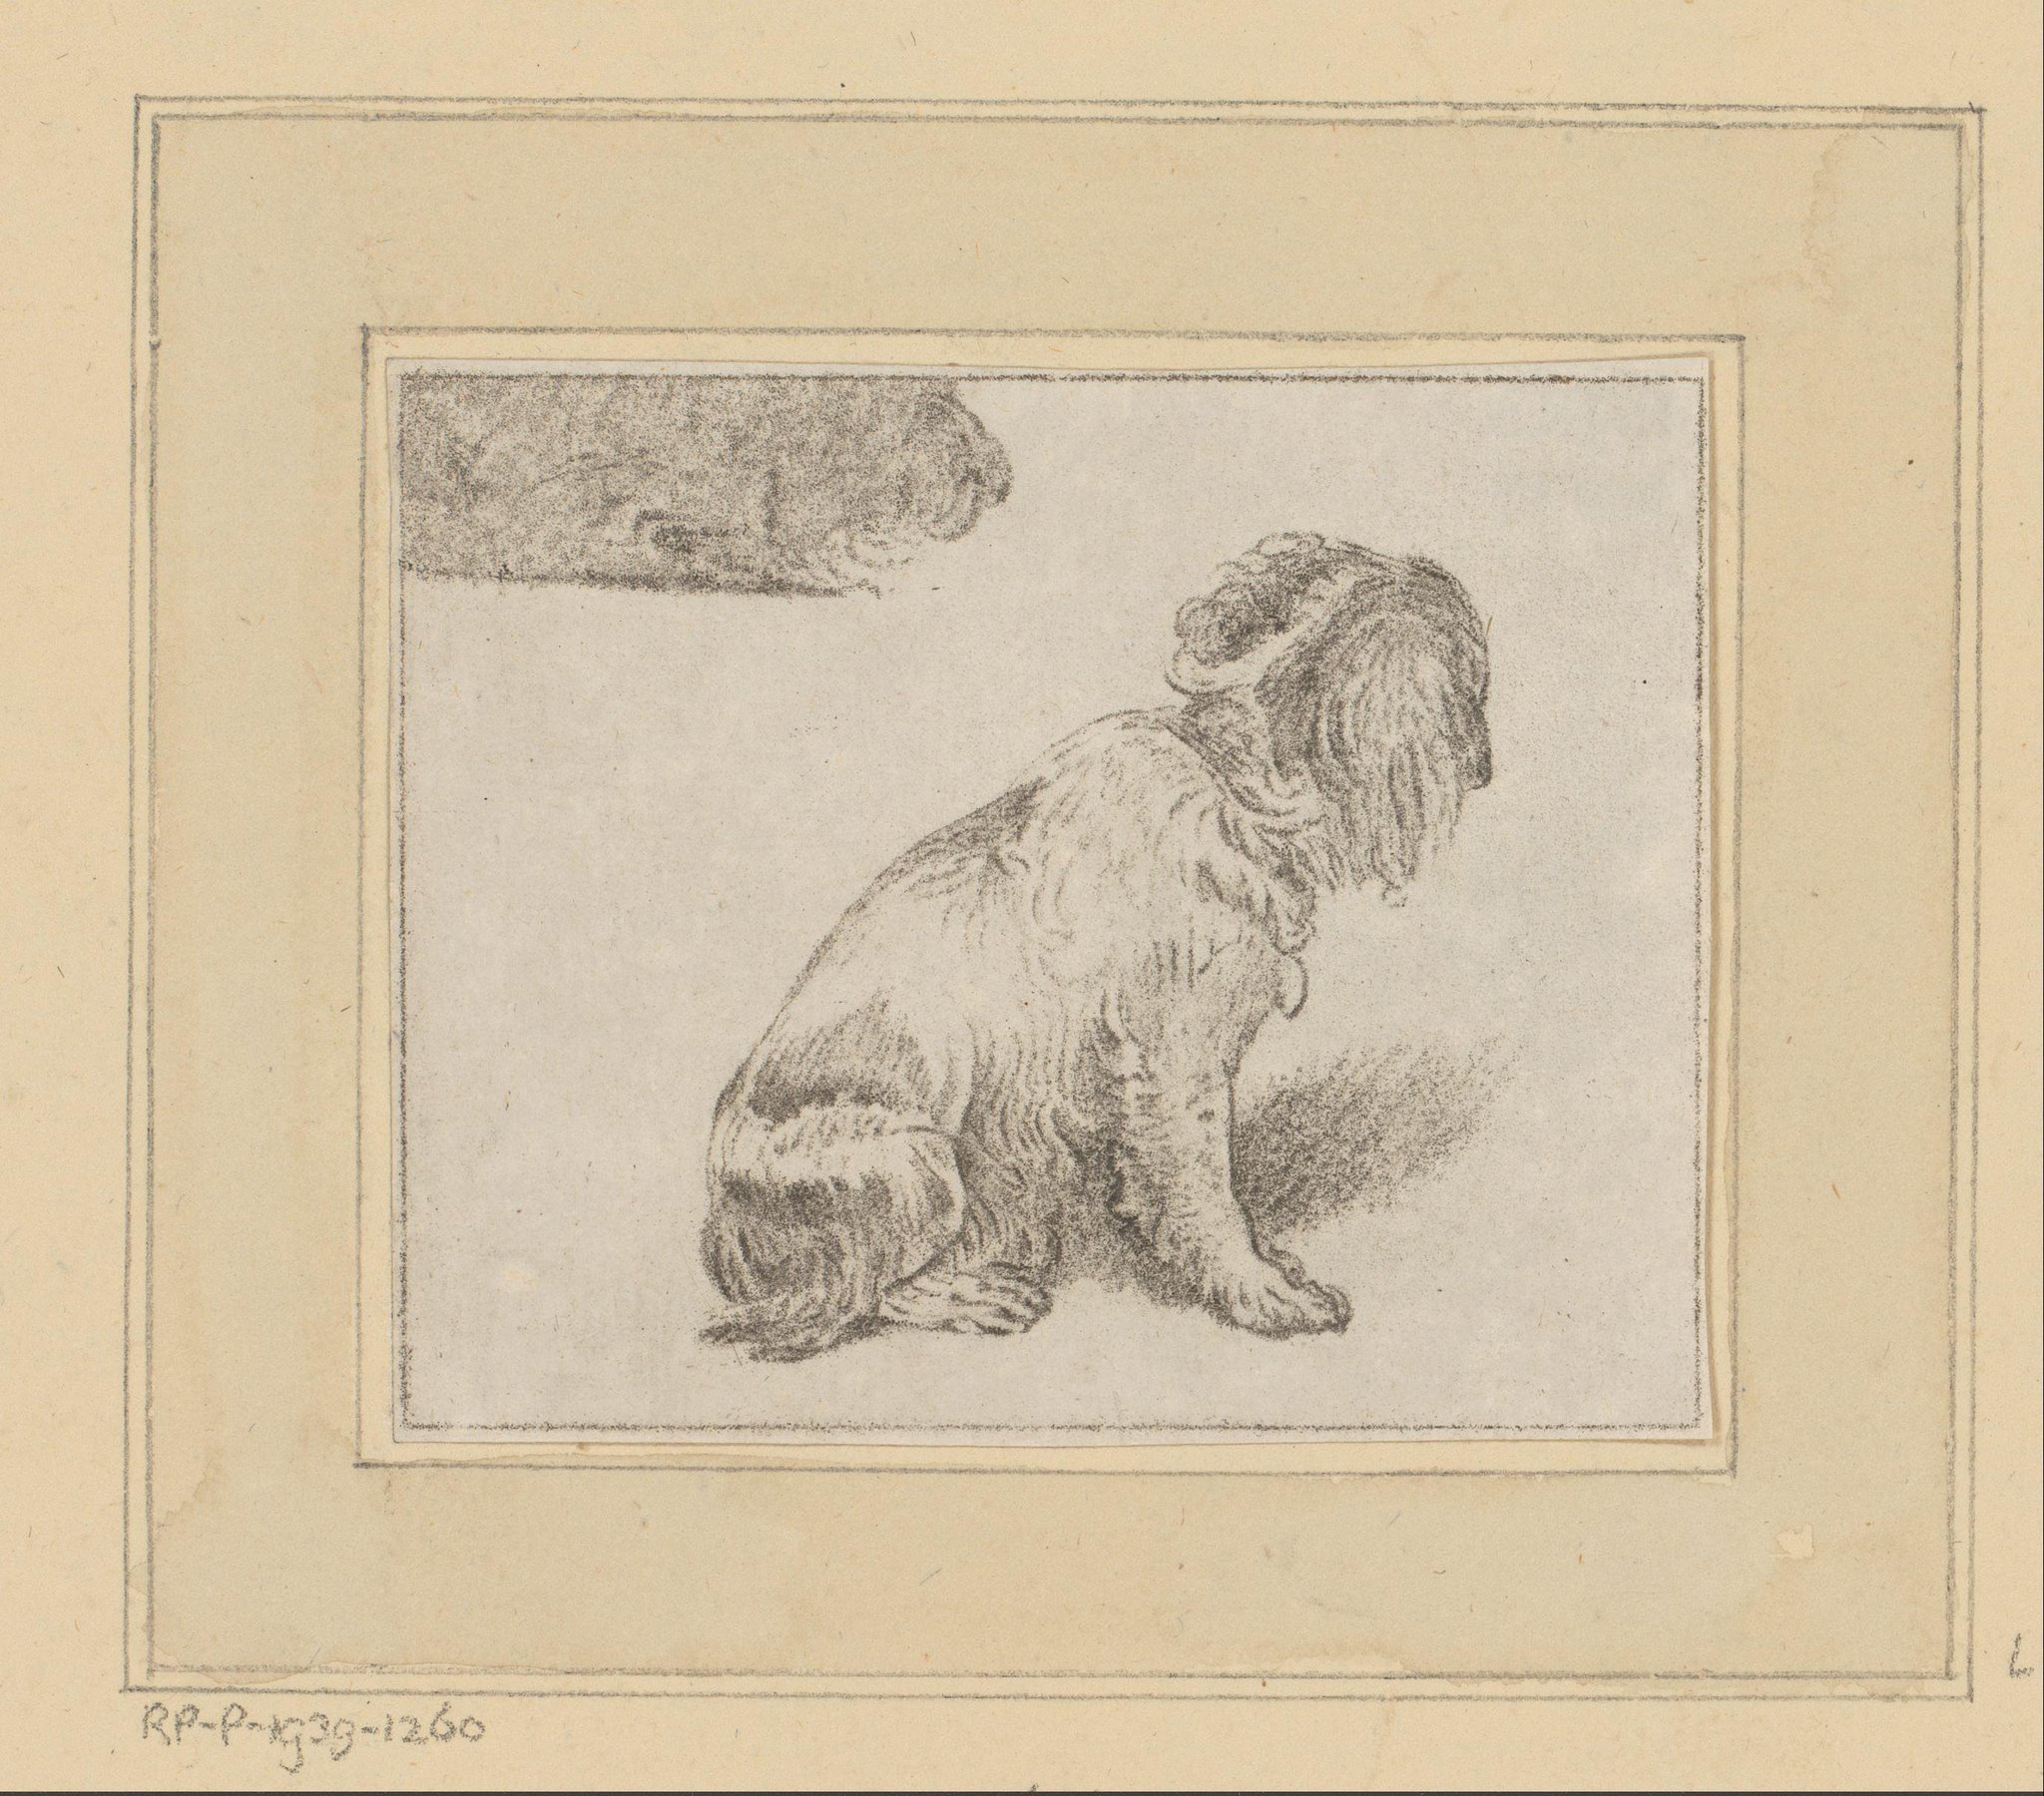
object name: print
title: Zittende hond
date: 1777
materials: paper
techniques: printmaking, etching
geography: amsterdam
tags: dog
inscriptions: inscription: ‘Fr v.Mieris del. 1663. CPloos v. Amstel J.C. F 1777’, collector's mark: Lugt 2725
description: De prent ligt los in een album, zie blad 28.